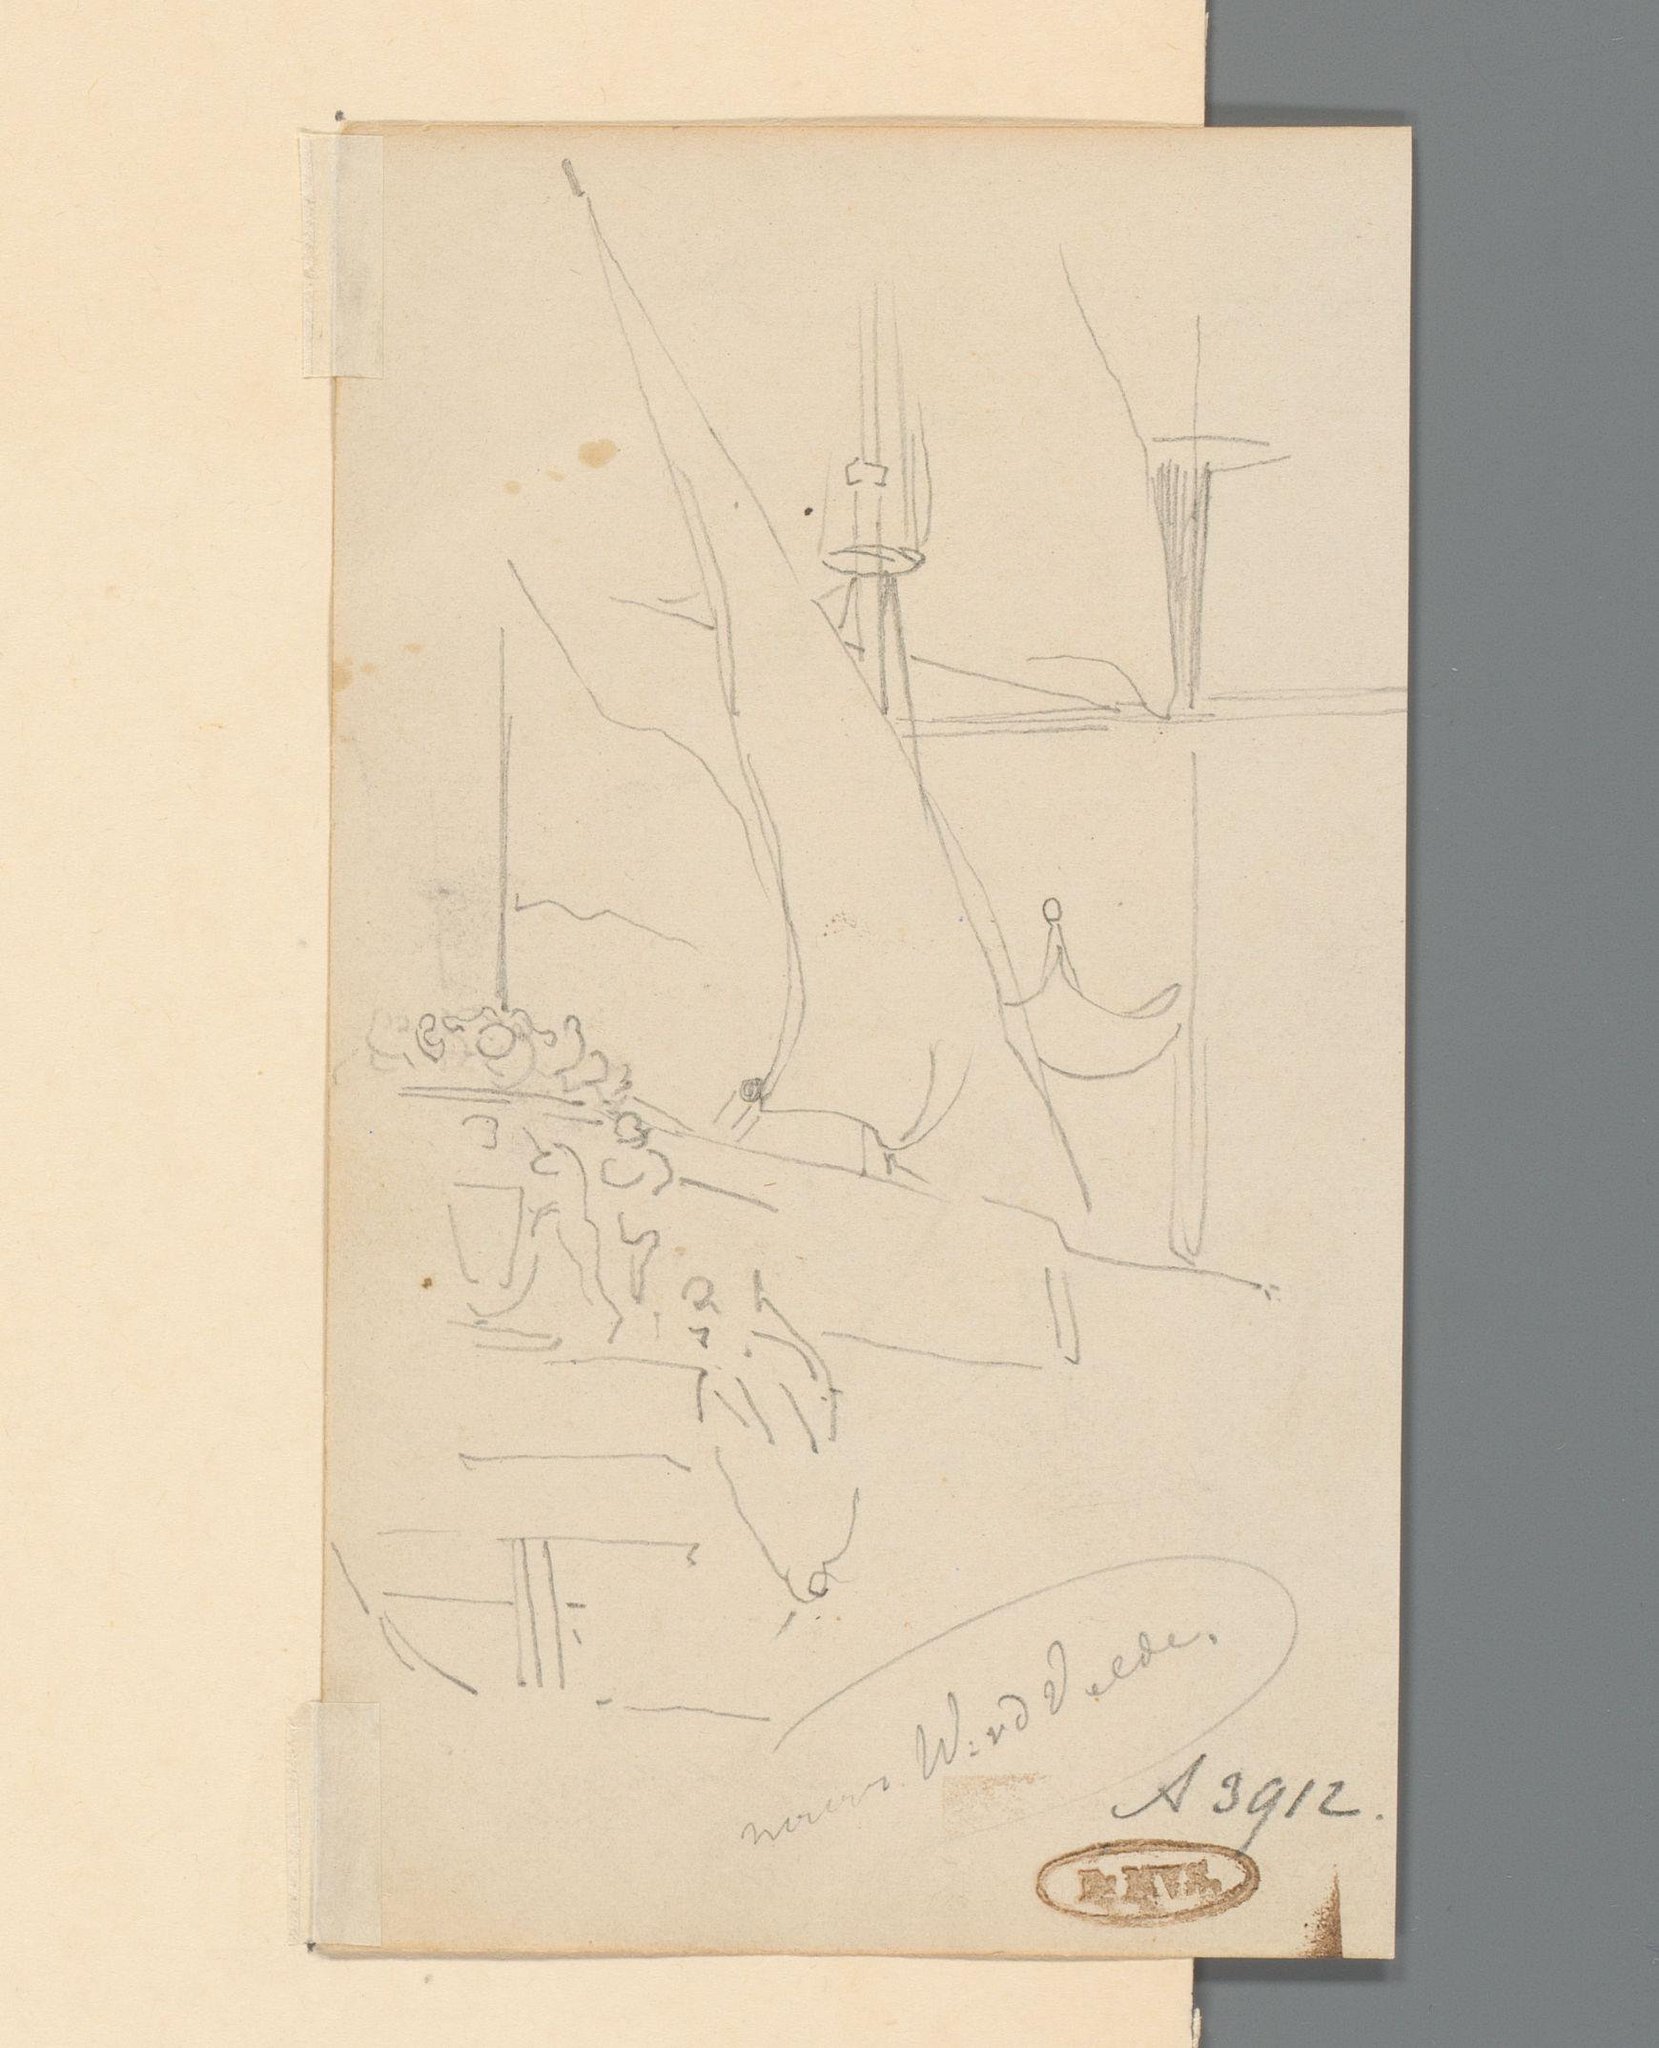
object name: drawing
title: Een fregat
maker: willem anthonie van deventer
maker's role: draughtsman, painter, print maker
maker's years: 1824-1893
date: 1834-1893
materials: paper, pencil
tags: sailing-ship, sailing-boat, navy (+ sailing-ships)